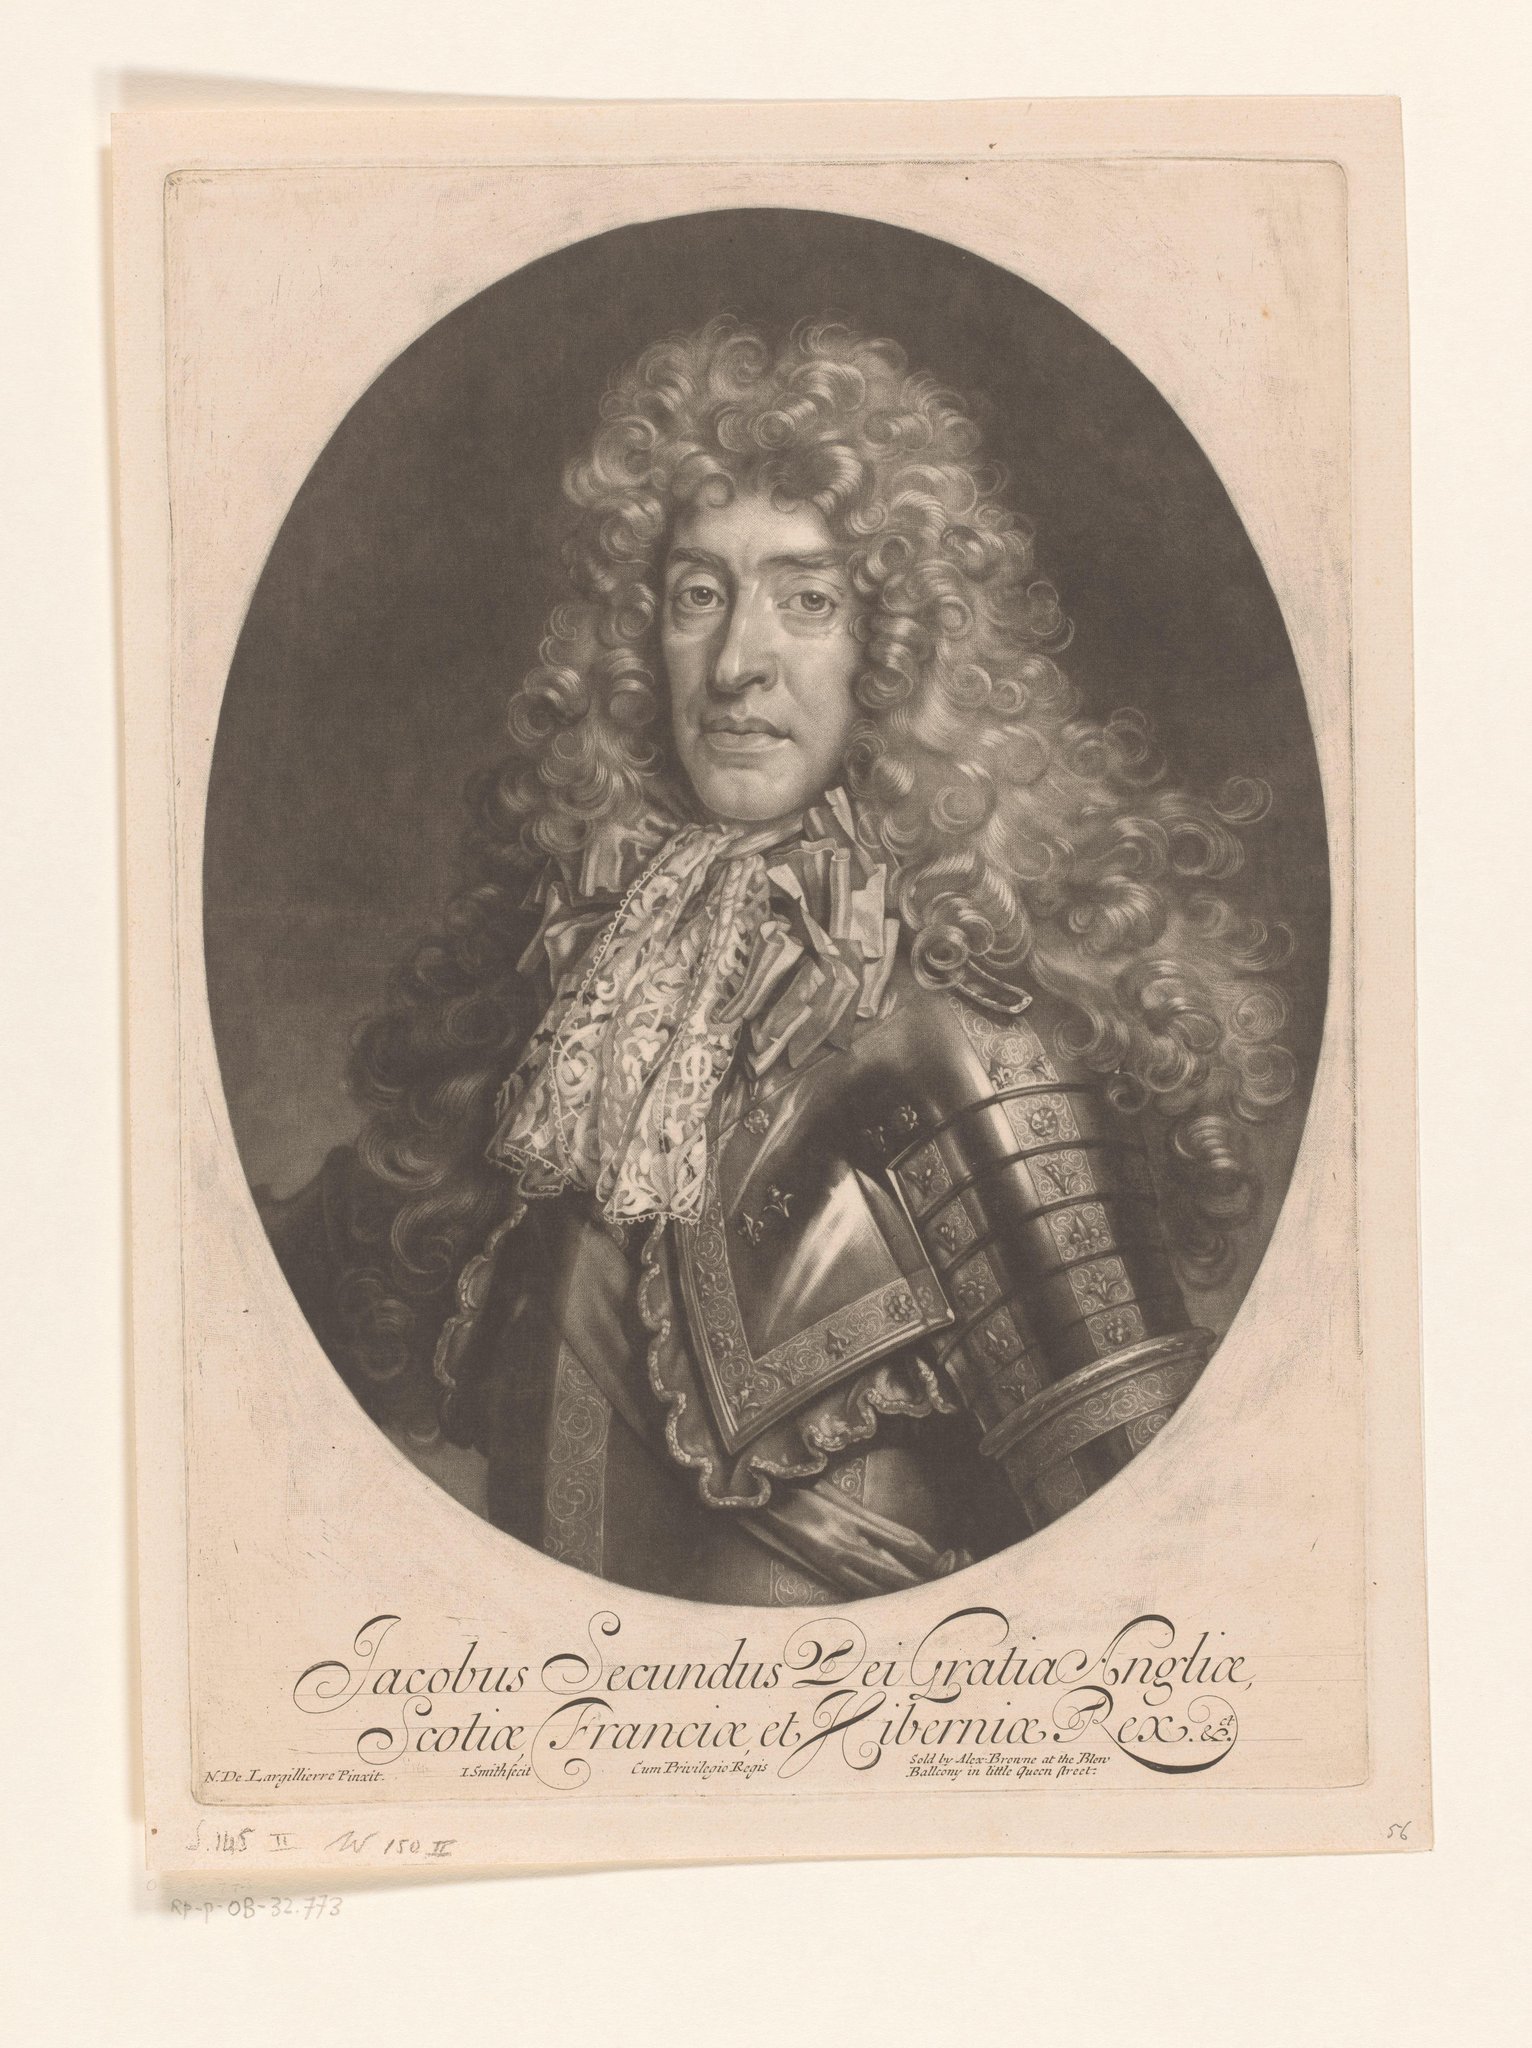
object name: print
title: Portret van Jacobus II, koning van Engeland en Schotland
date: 1662-1742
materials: paper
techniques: mezzotint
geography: london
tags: jacobus ii (koning van engeland en schotland), historical persons, king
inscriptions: collector's mark: Lugt 240